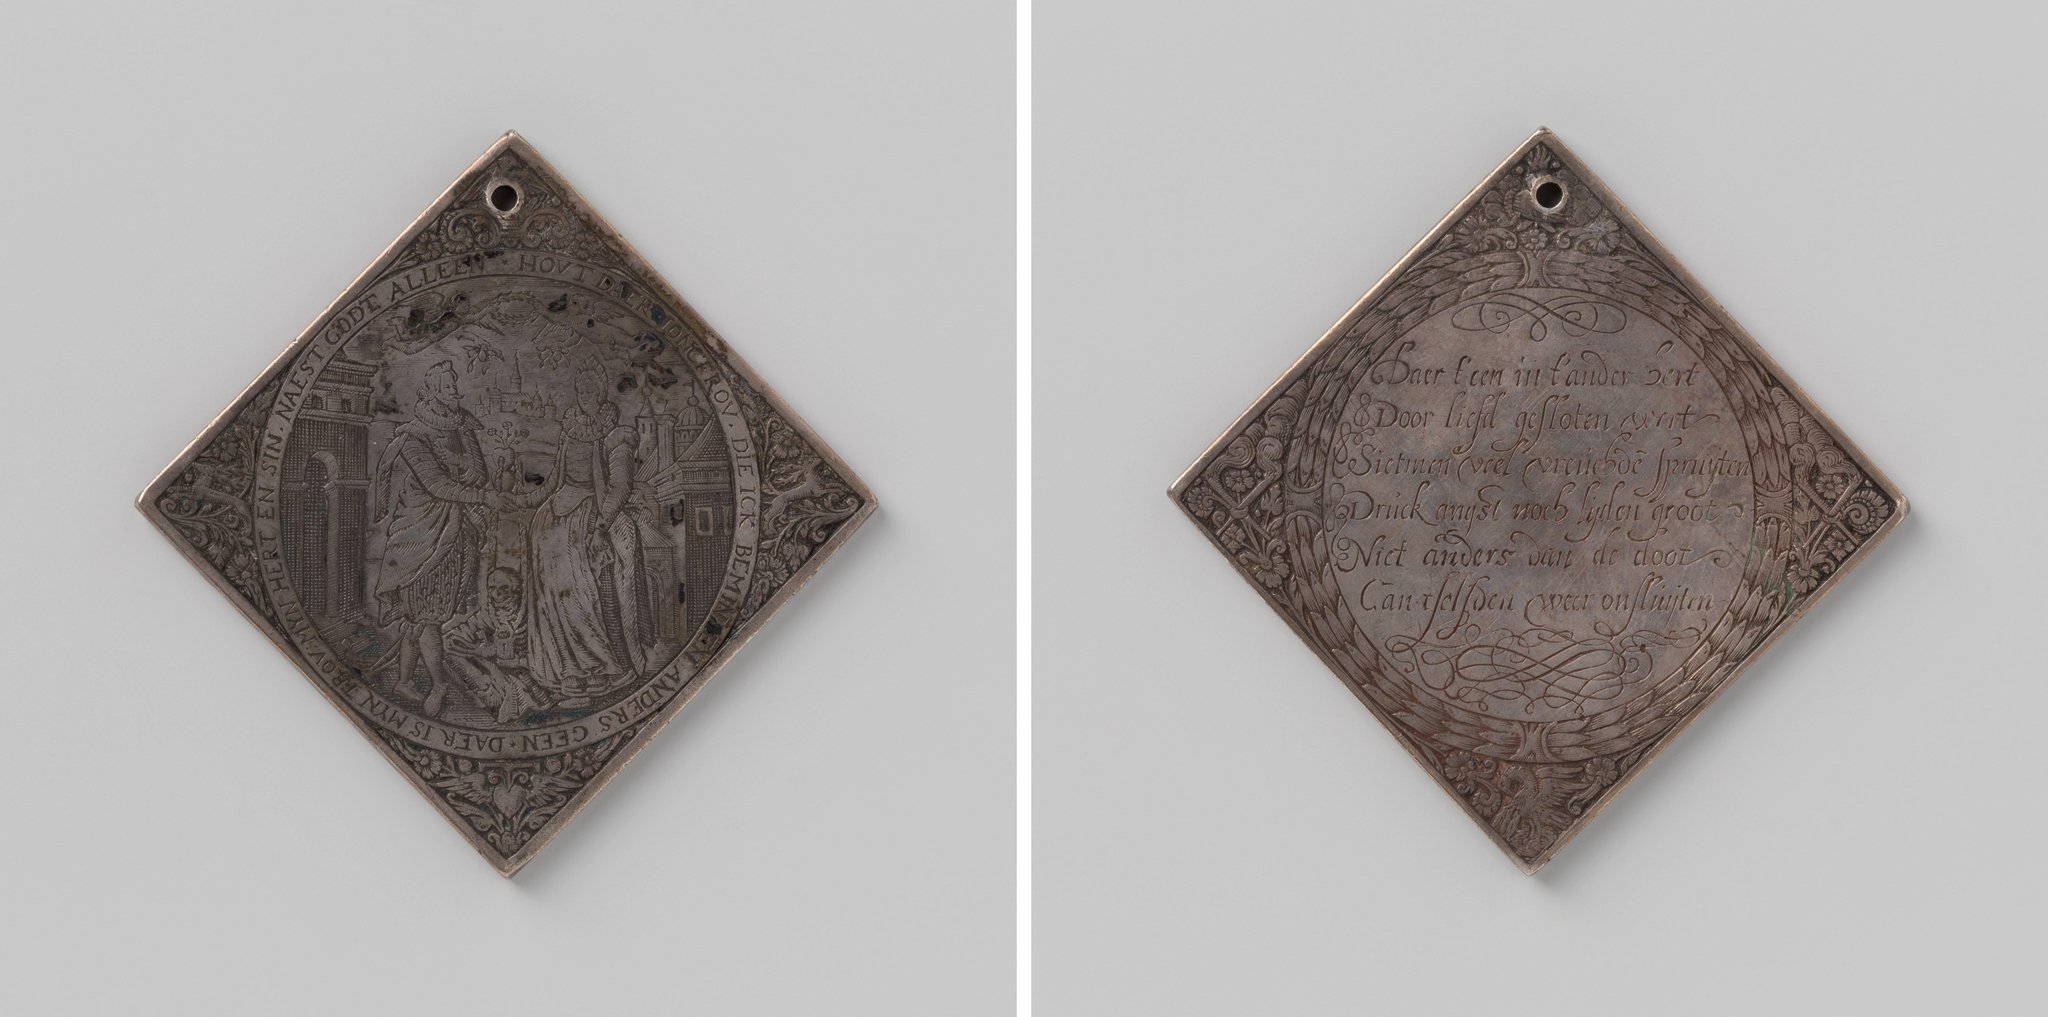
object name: family medal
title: het huwelijk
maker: monogrammist ab (1626-1686)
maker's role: medailleur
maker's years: 1626-1686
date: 1650-1686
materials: silver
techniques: engraving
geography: netherlands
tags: marriage, married couple, 'matrimonium'